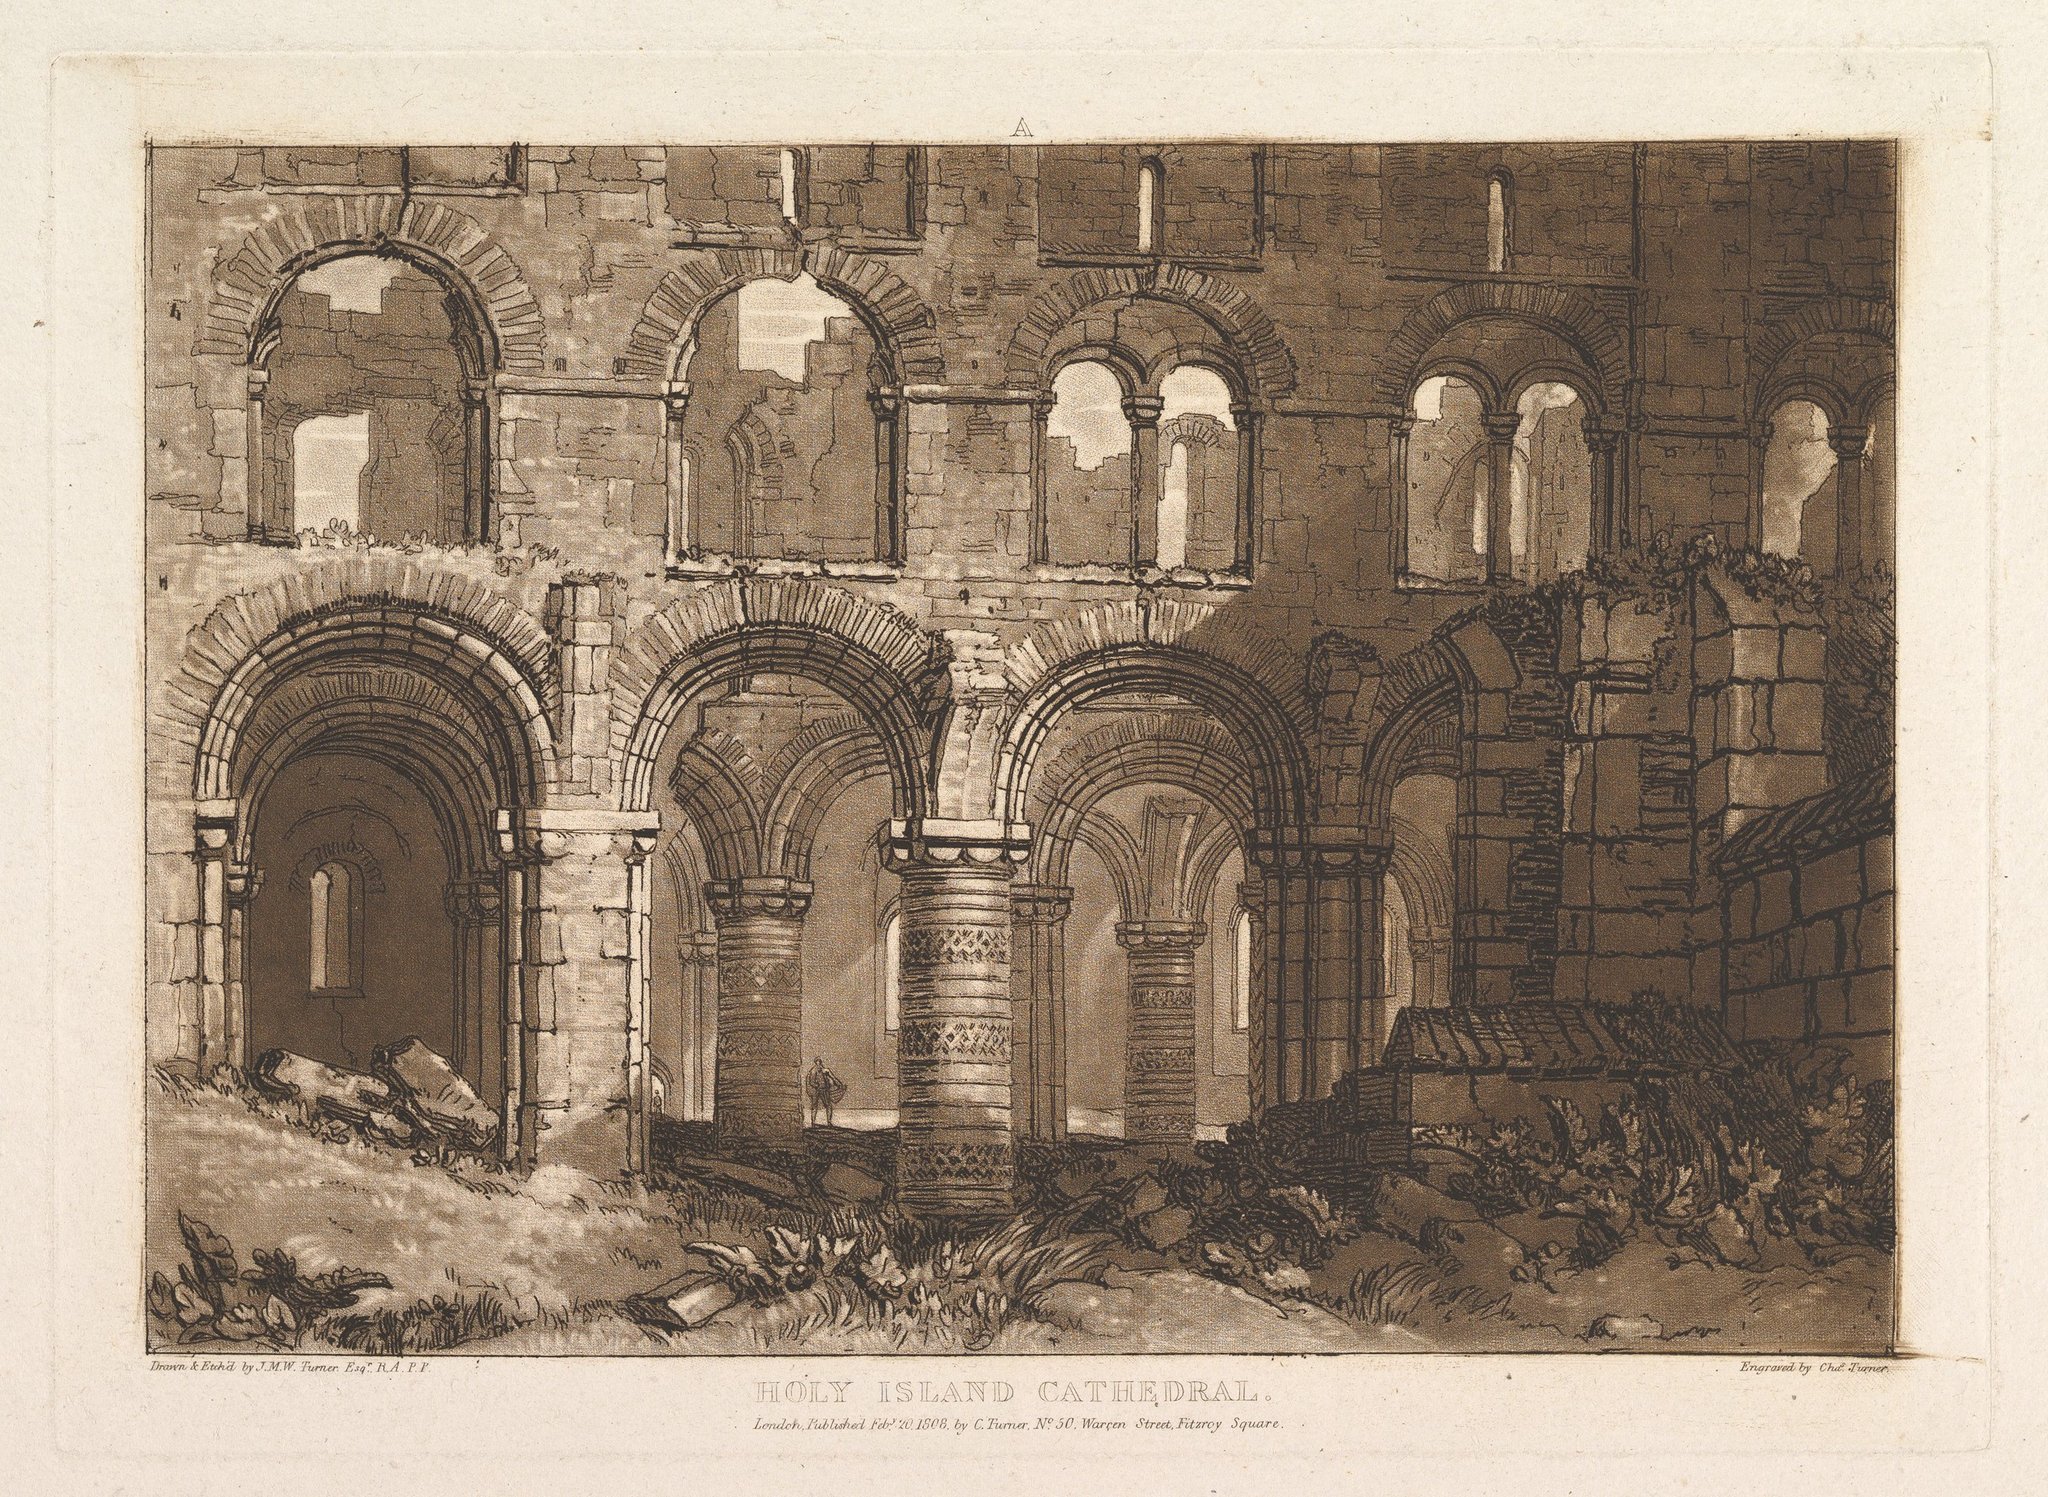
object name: print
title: Holy Island Cathedral, part III, plate 11 from "Liber Studiorum"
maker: joseph mallord william turner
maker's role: artist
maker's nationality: british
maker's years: 1775-1851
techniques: etching, mezzotint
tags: arches,cathedrals